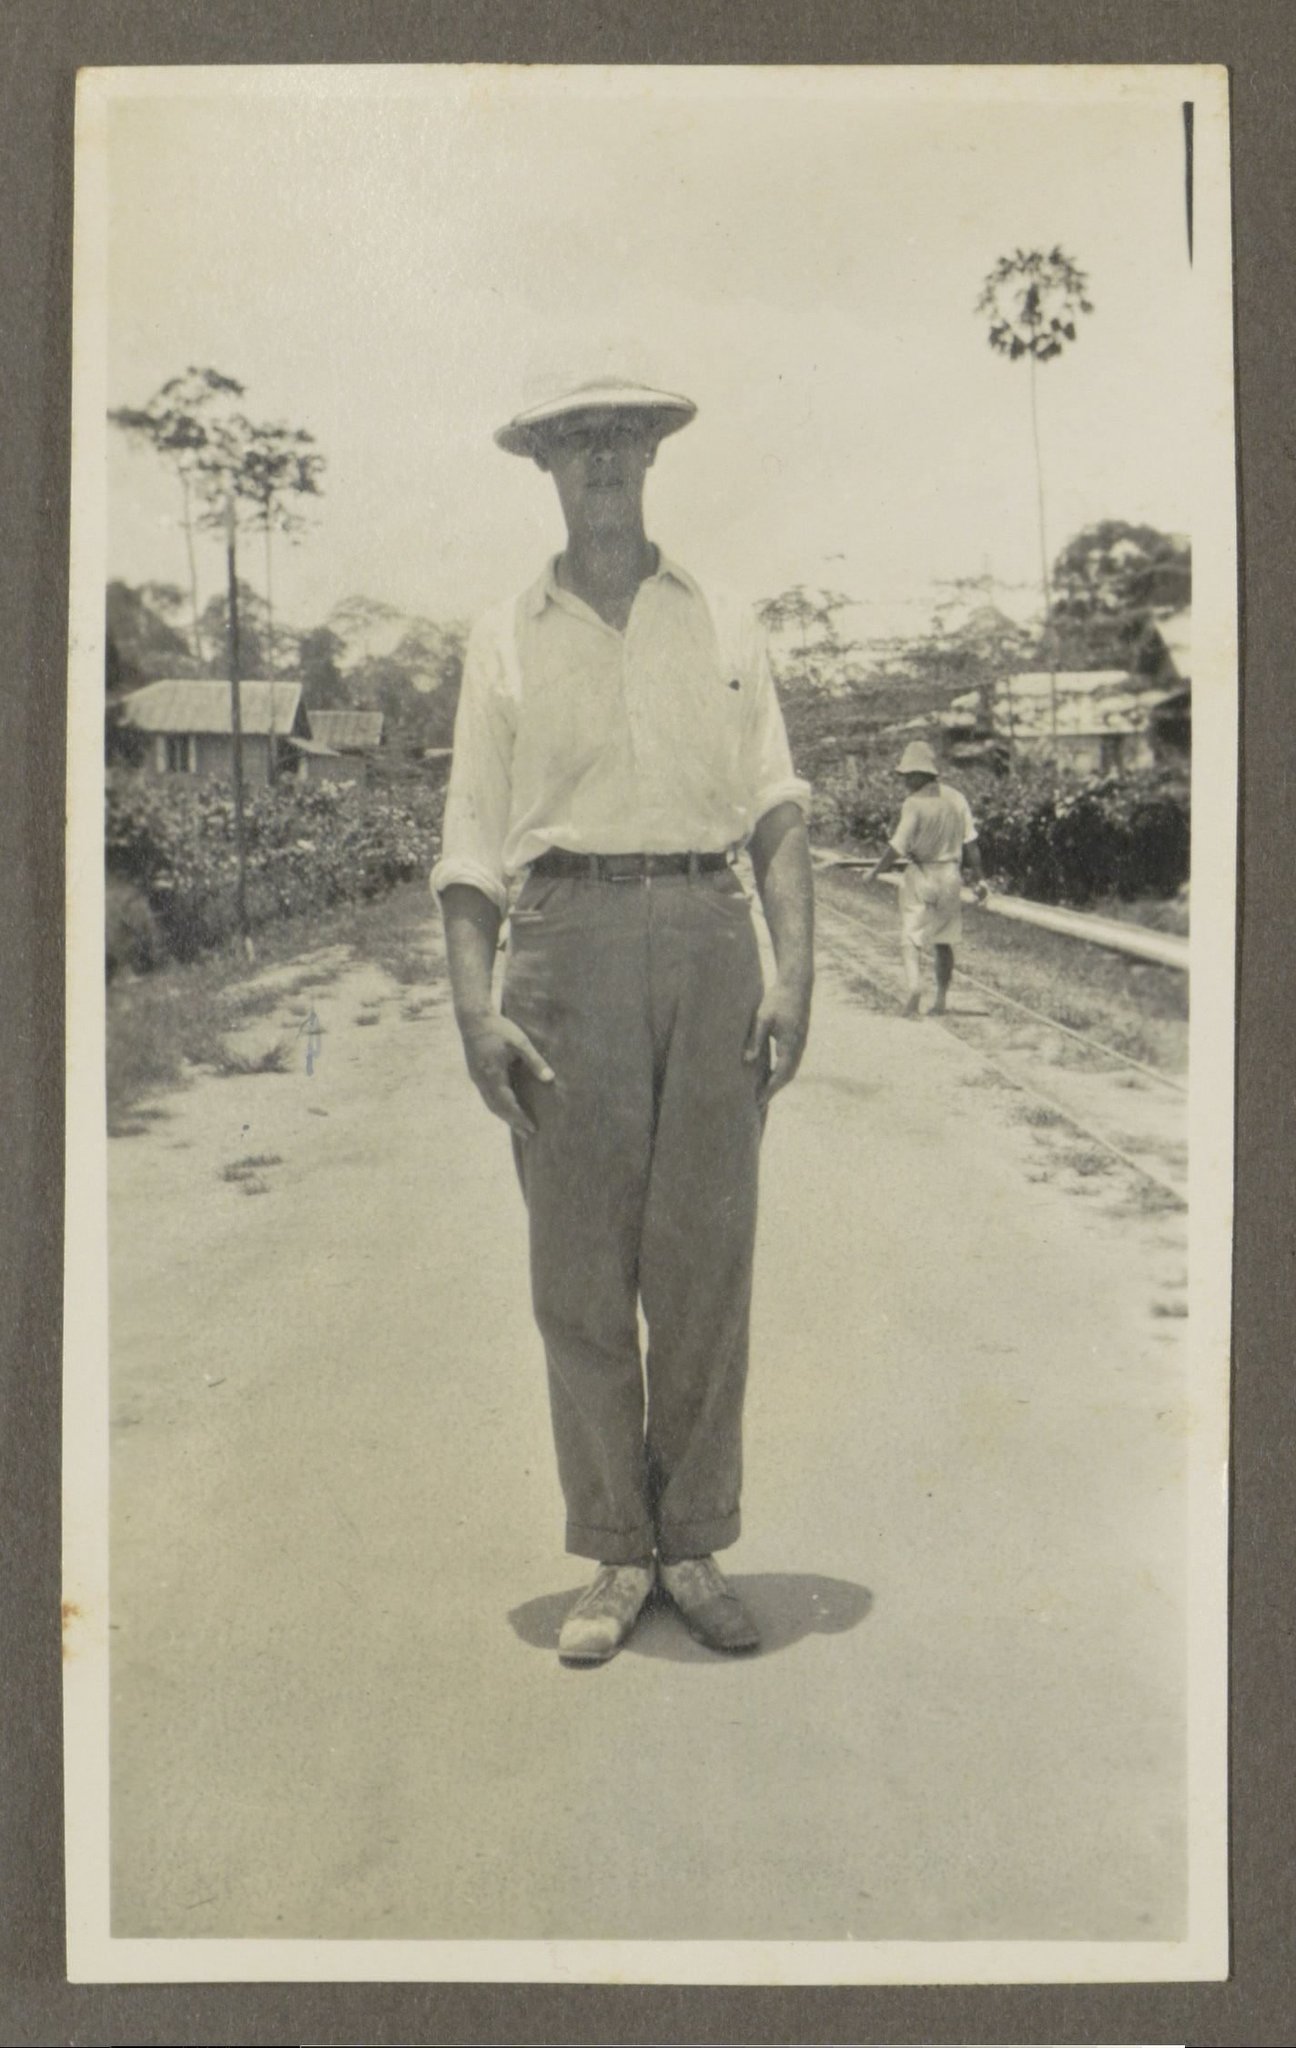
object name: photograph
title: Man met een tropenhelm poserend op een weg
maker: Anonymous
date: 1920-1930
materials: photographic support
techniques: gelatin silver print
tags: dutch east indies, the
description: Onderdeel van familiealbum Nederlands-Indië.